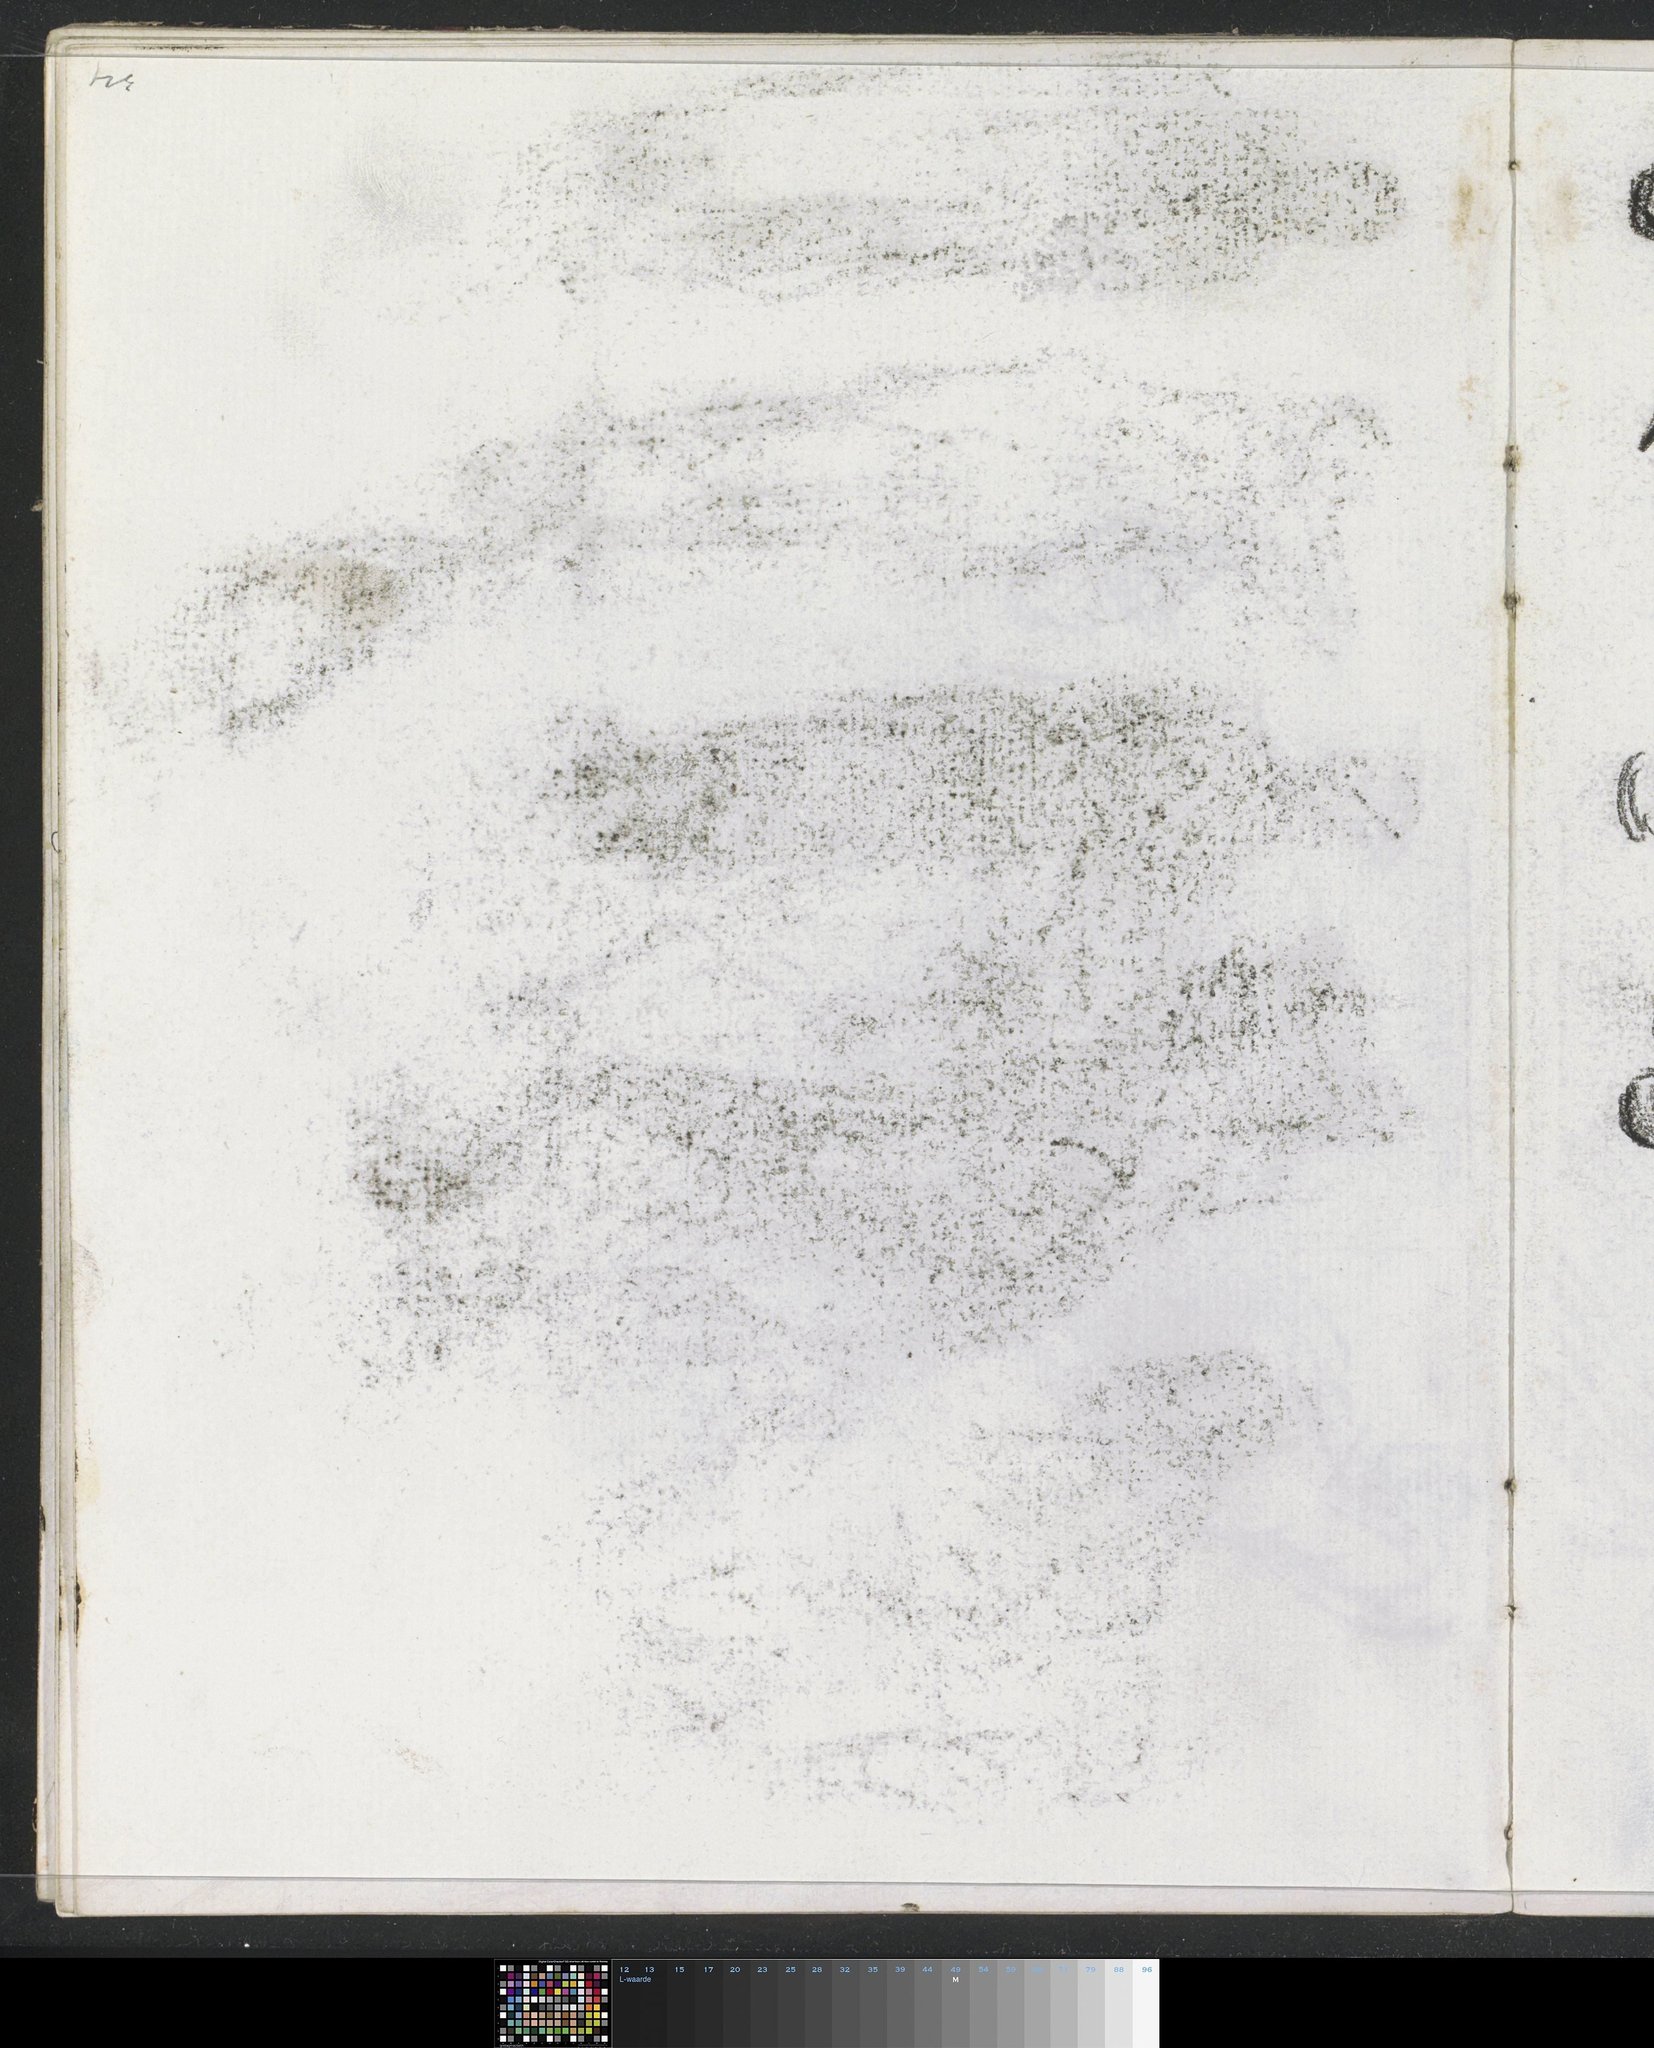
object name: sketchbook leaf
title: Abklatsch van de krijttekening op blad 18 recto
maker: isaac israels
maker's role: draughtsman, painter, print maker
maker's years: 1865-1934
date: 1875-1934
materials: paper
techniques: printmaking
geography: the hague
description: Blad 17 verso uit schetsboek XIII met 25 bladen.